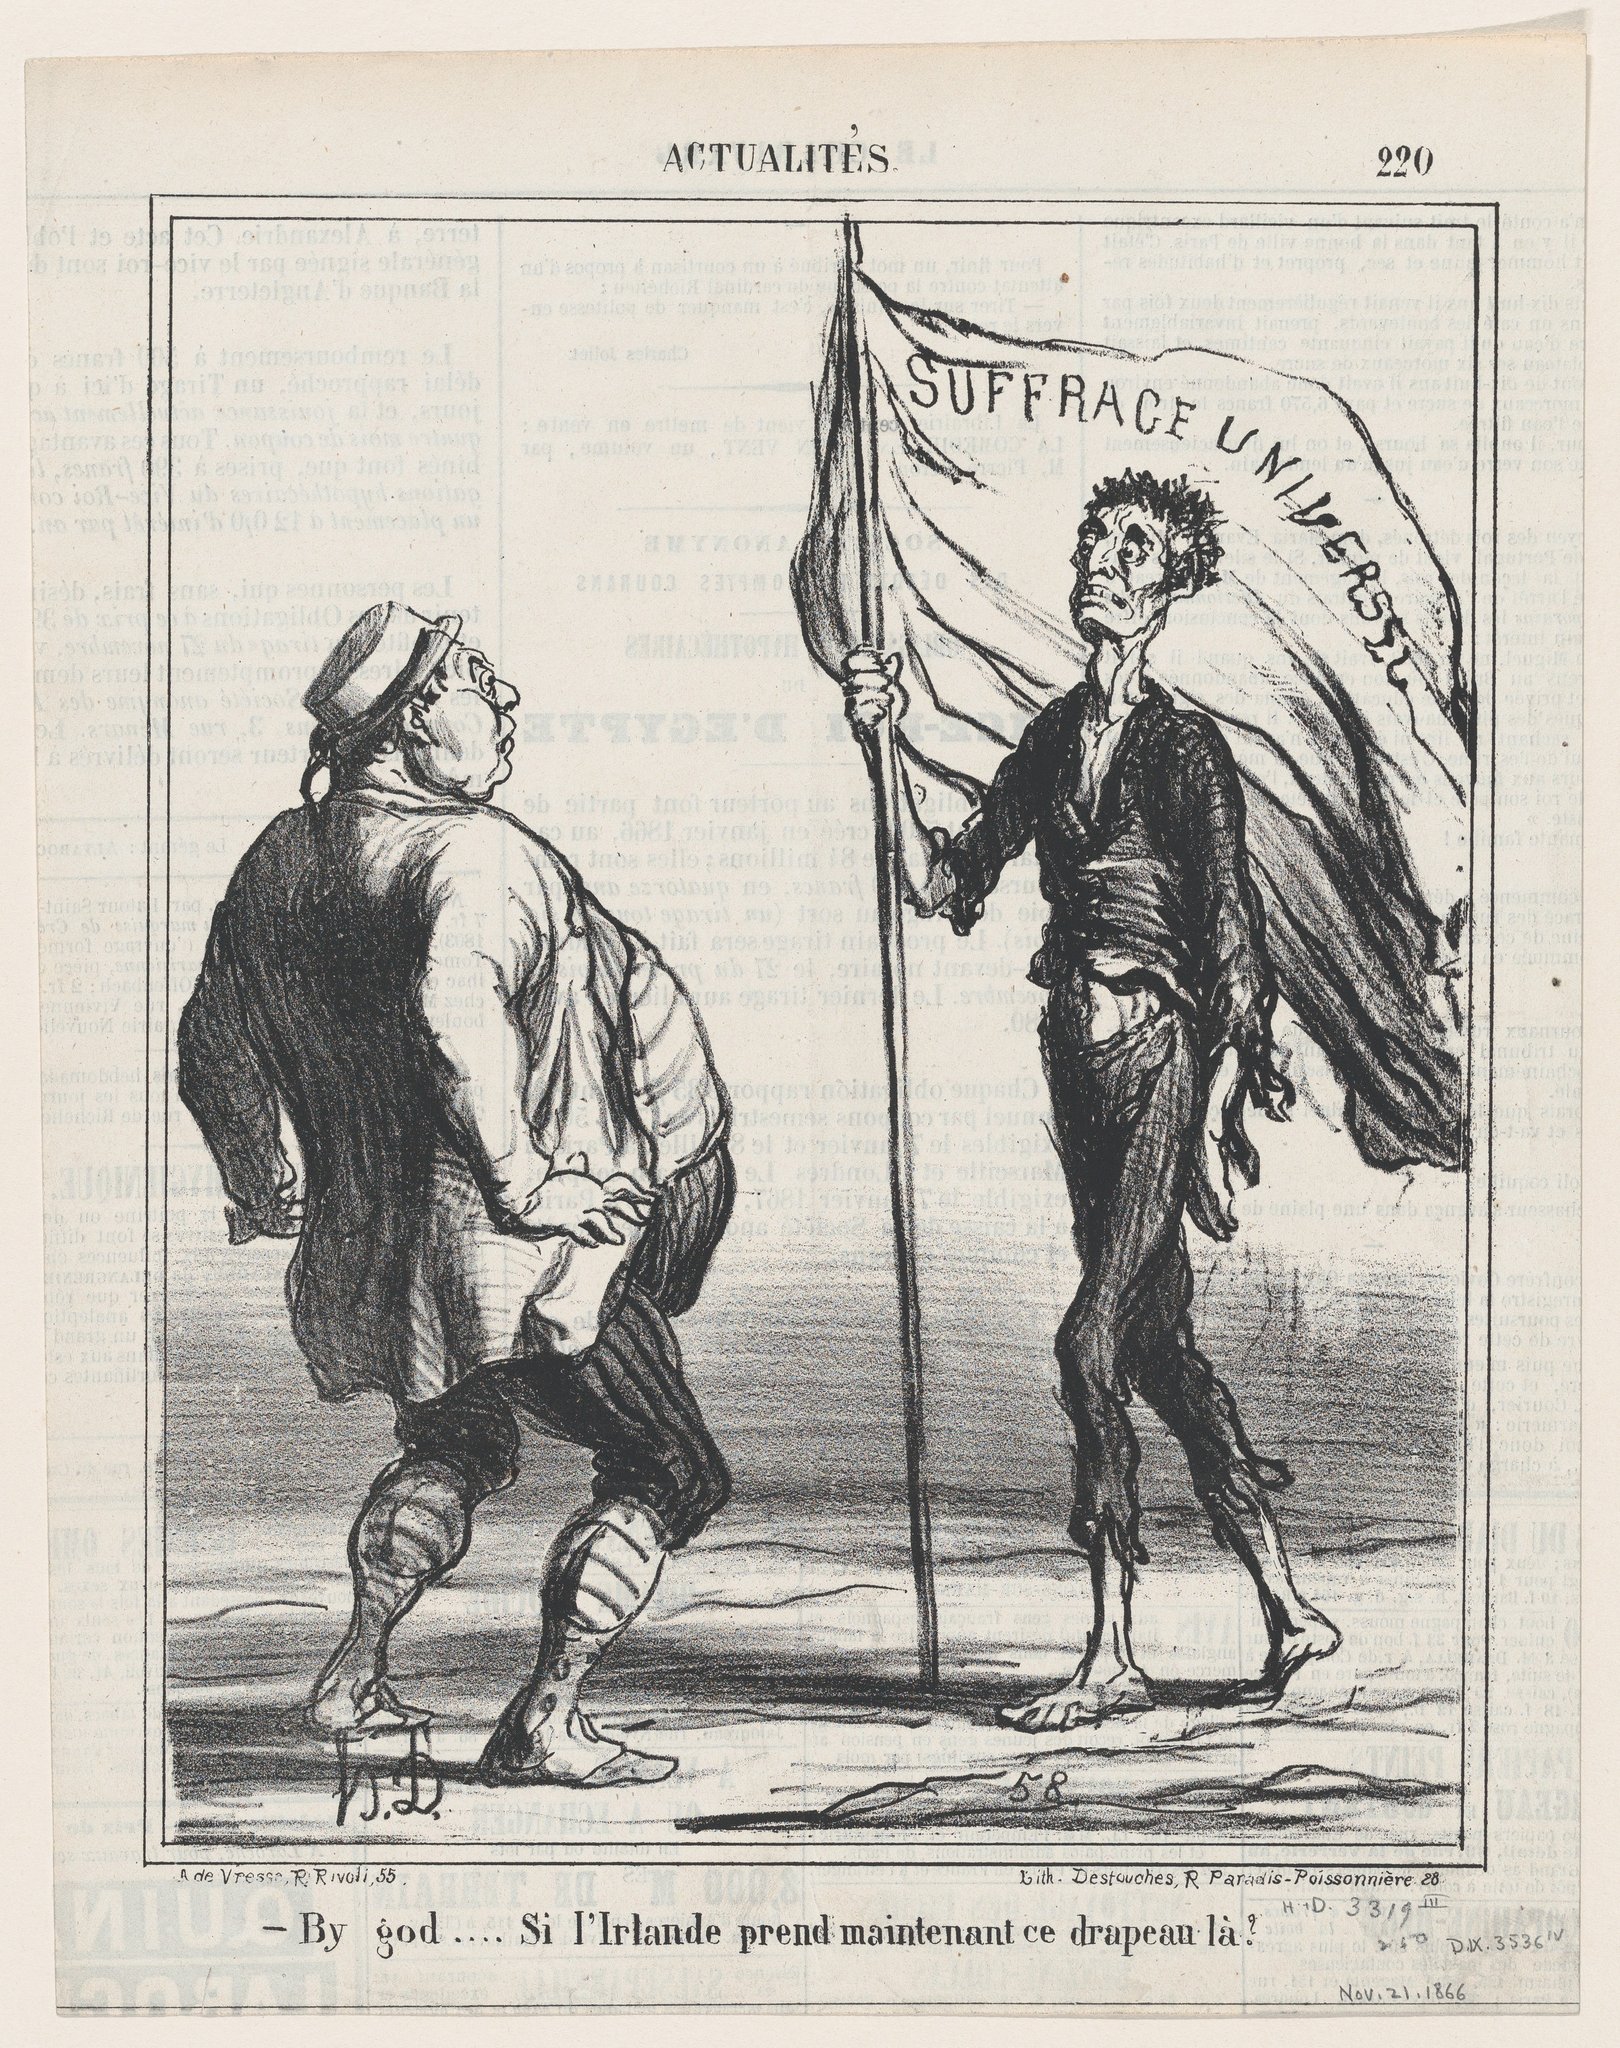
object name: print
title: By God! If Ireland should really wave this flag now!, from "News of the Day"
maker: honoré daumier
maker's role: artist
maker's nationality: french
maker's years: 1808-1879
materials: paper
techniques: lithograph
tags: satire,men,flags